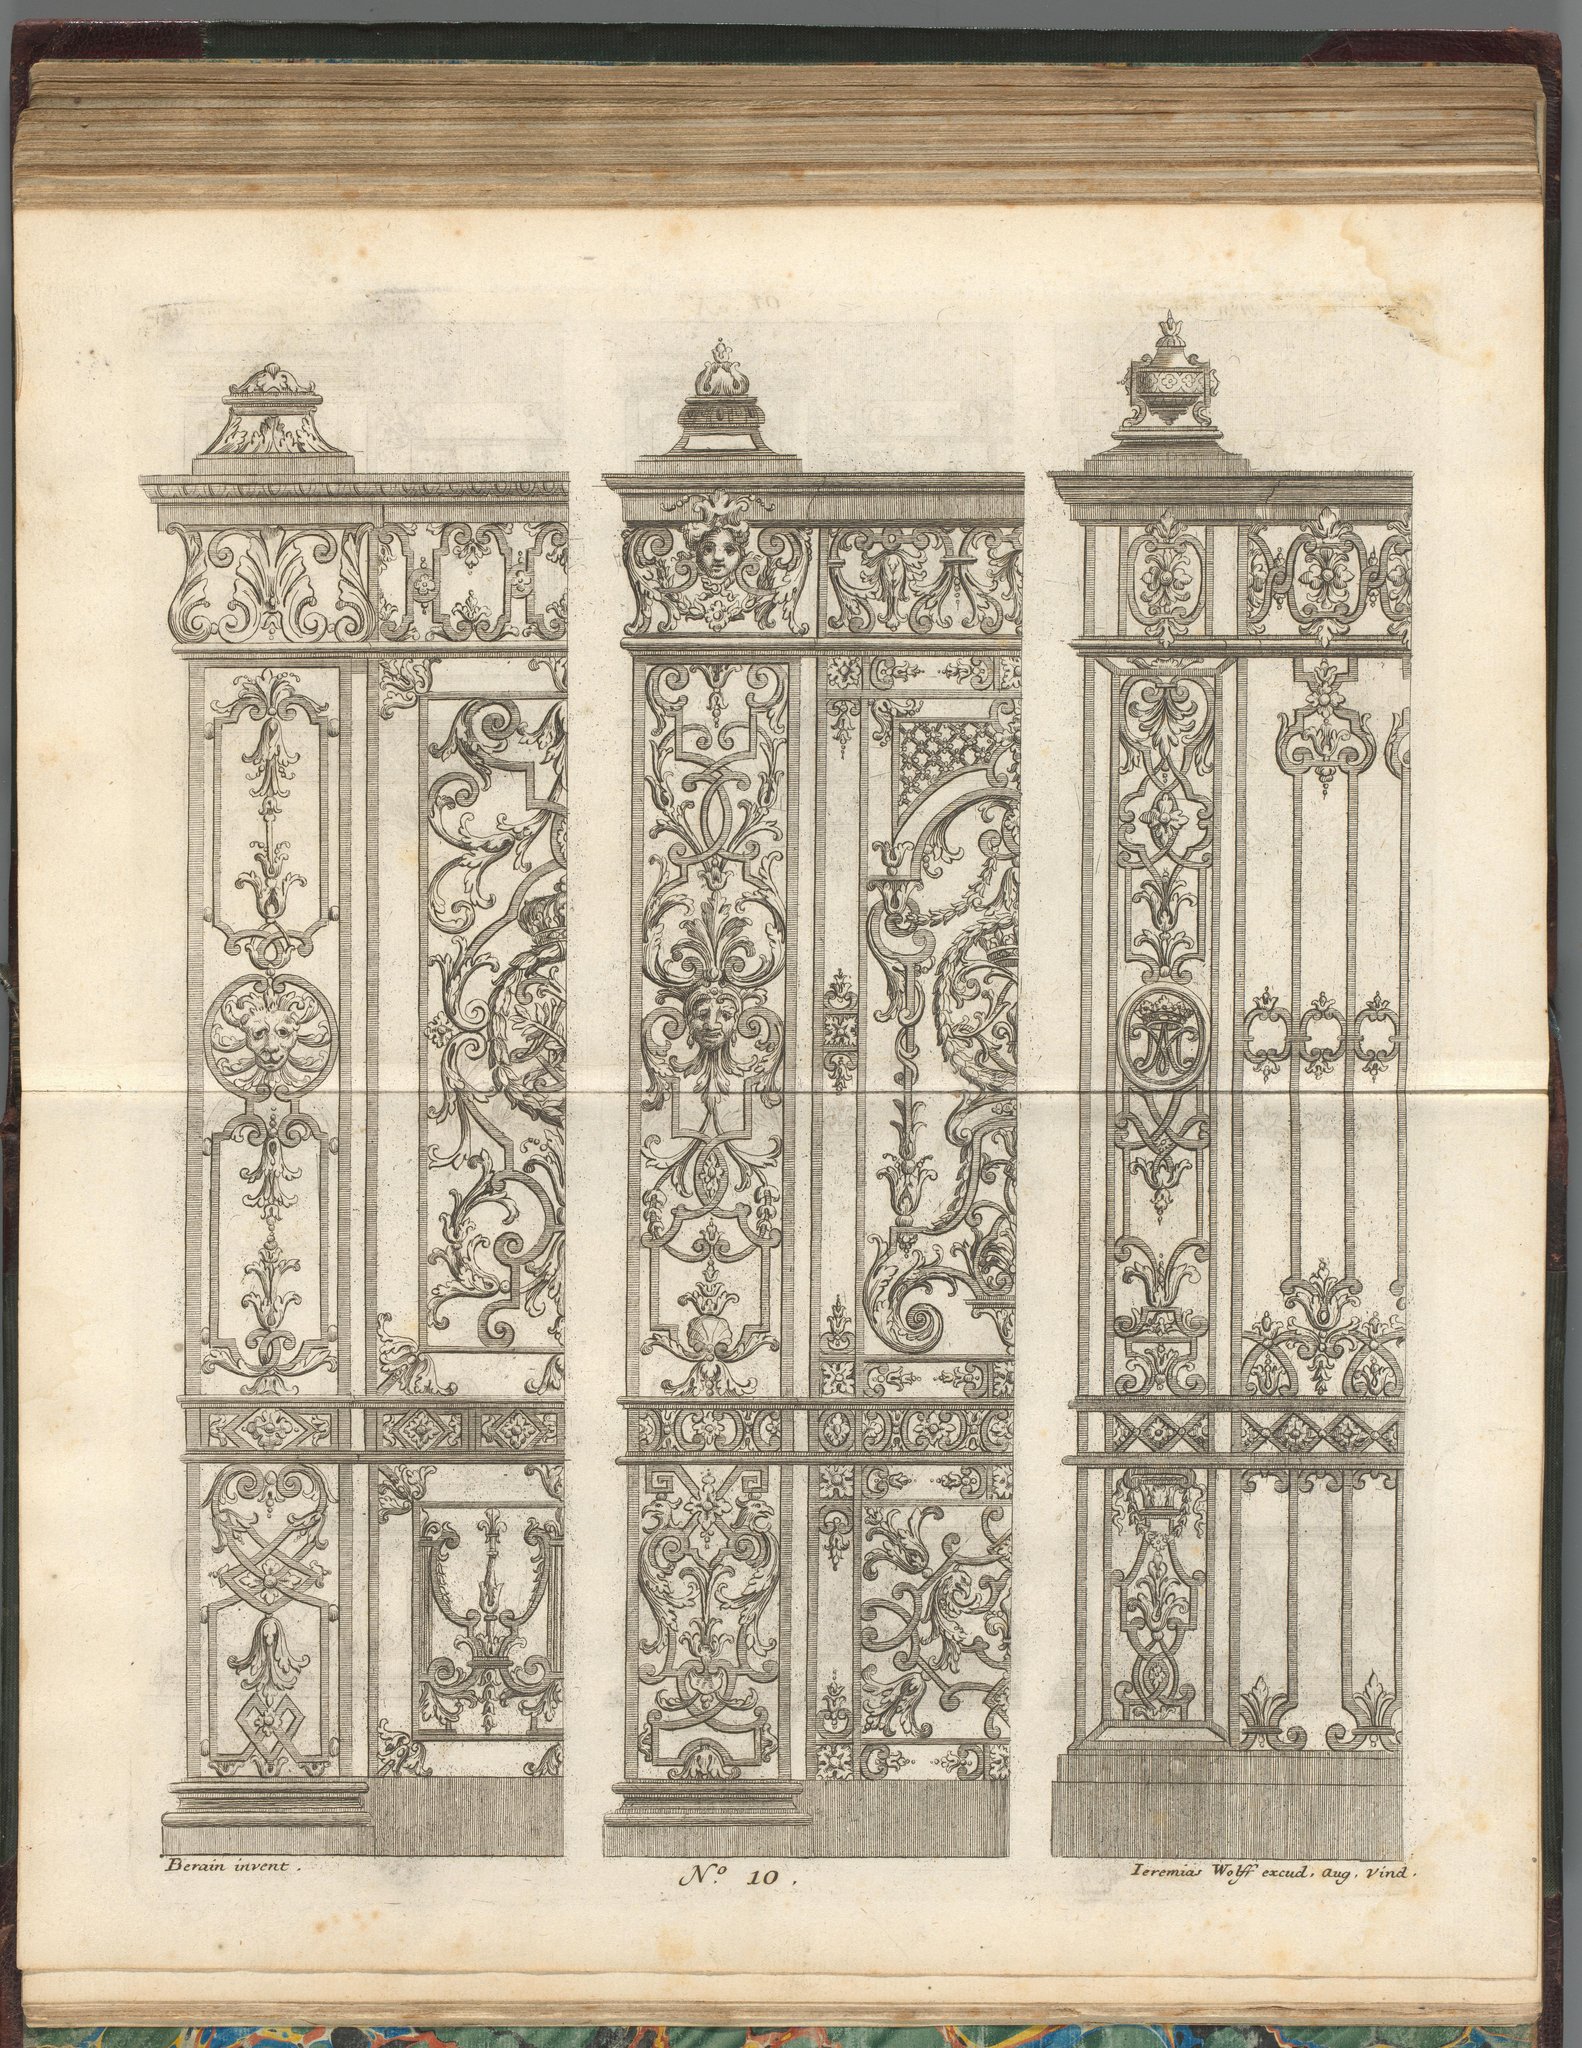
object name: ornament print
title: Ontwerpen voor hekken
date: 1686-1724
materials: paper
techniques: etching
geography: augsburg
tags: ornaments ~ art, gate, entrance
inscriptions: signature: ‘Ieremias Wolff excud. Aug. Vind.’, number: ‘No. 10.’, signature: ‘Berain invent.’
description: Drie hekken met een hoek pilaster, elk met een monogram in een medaillon. Eerste prent uit een serie van vijf. Prent maakt deel uit van een album. Gespiegelde kopie naar Frans origineel.